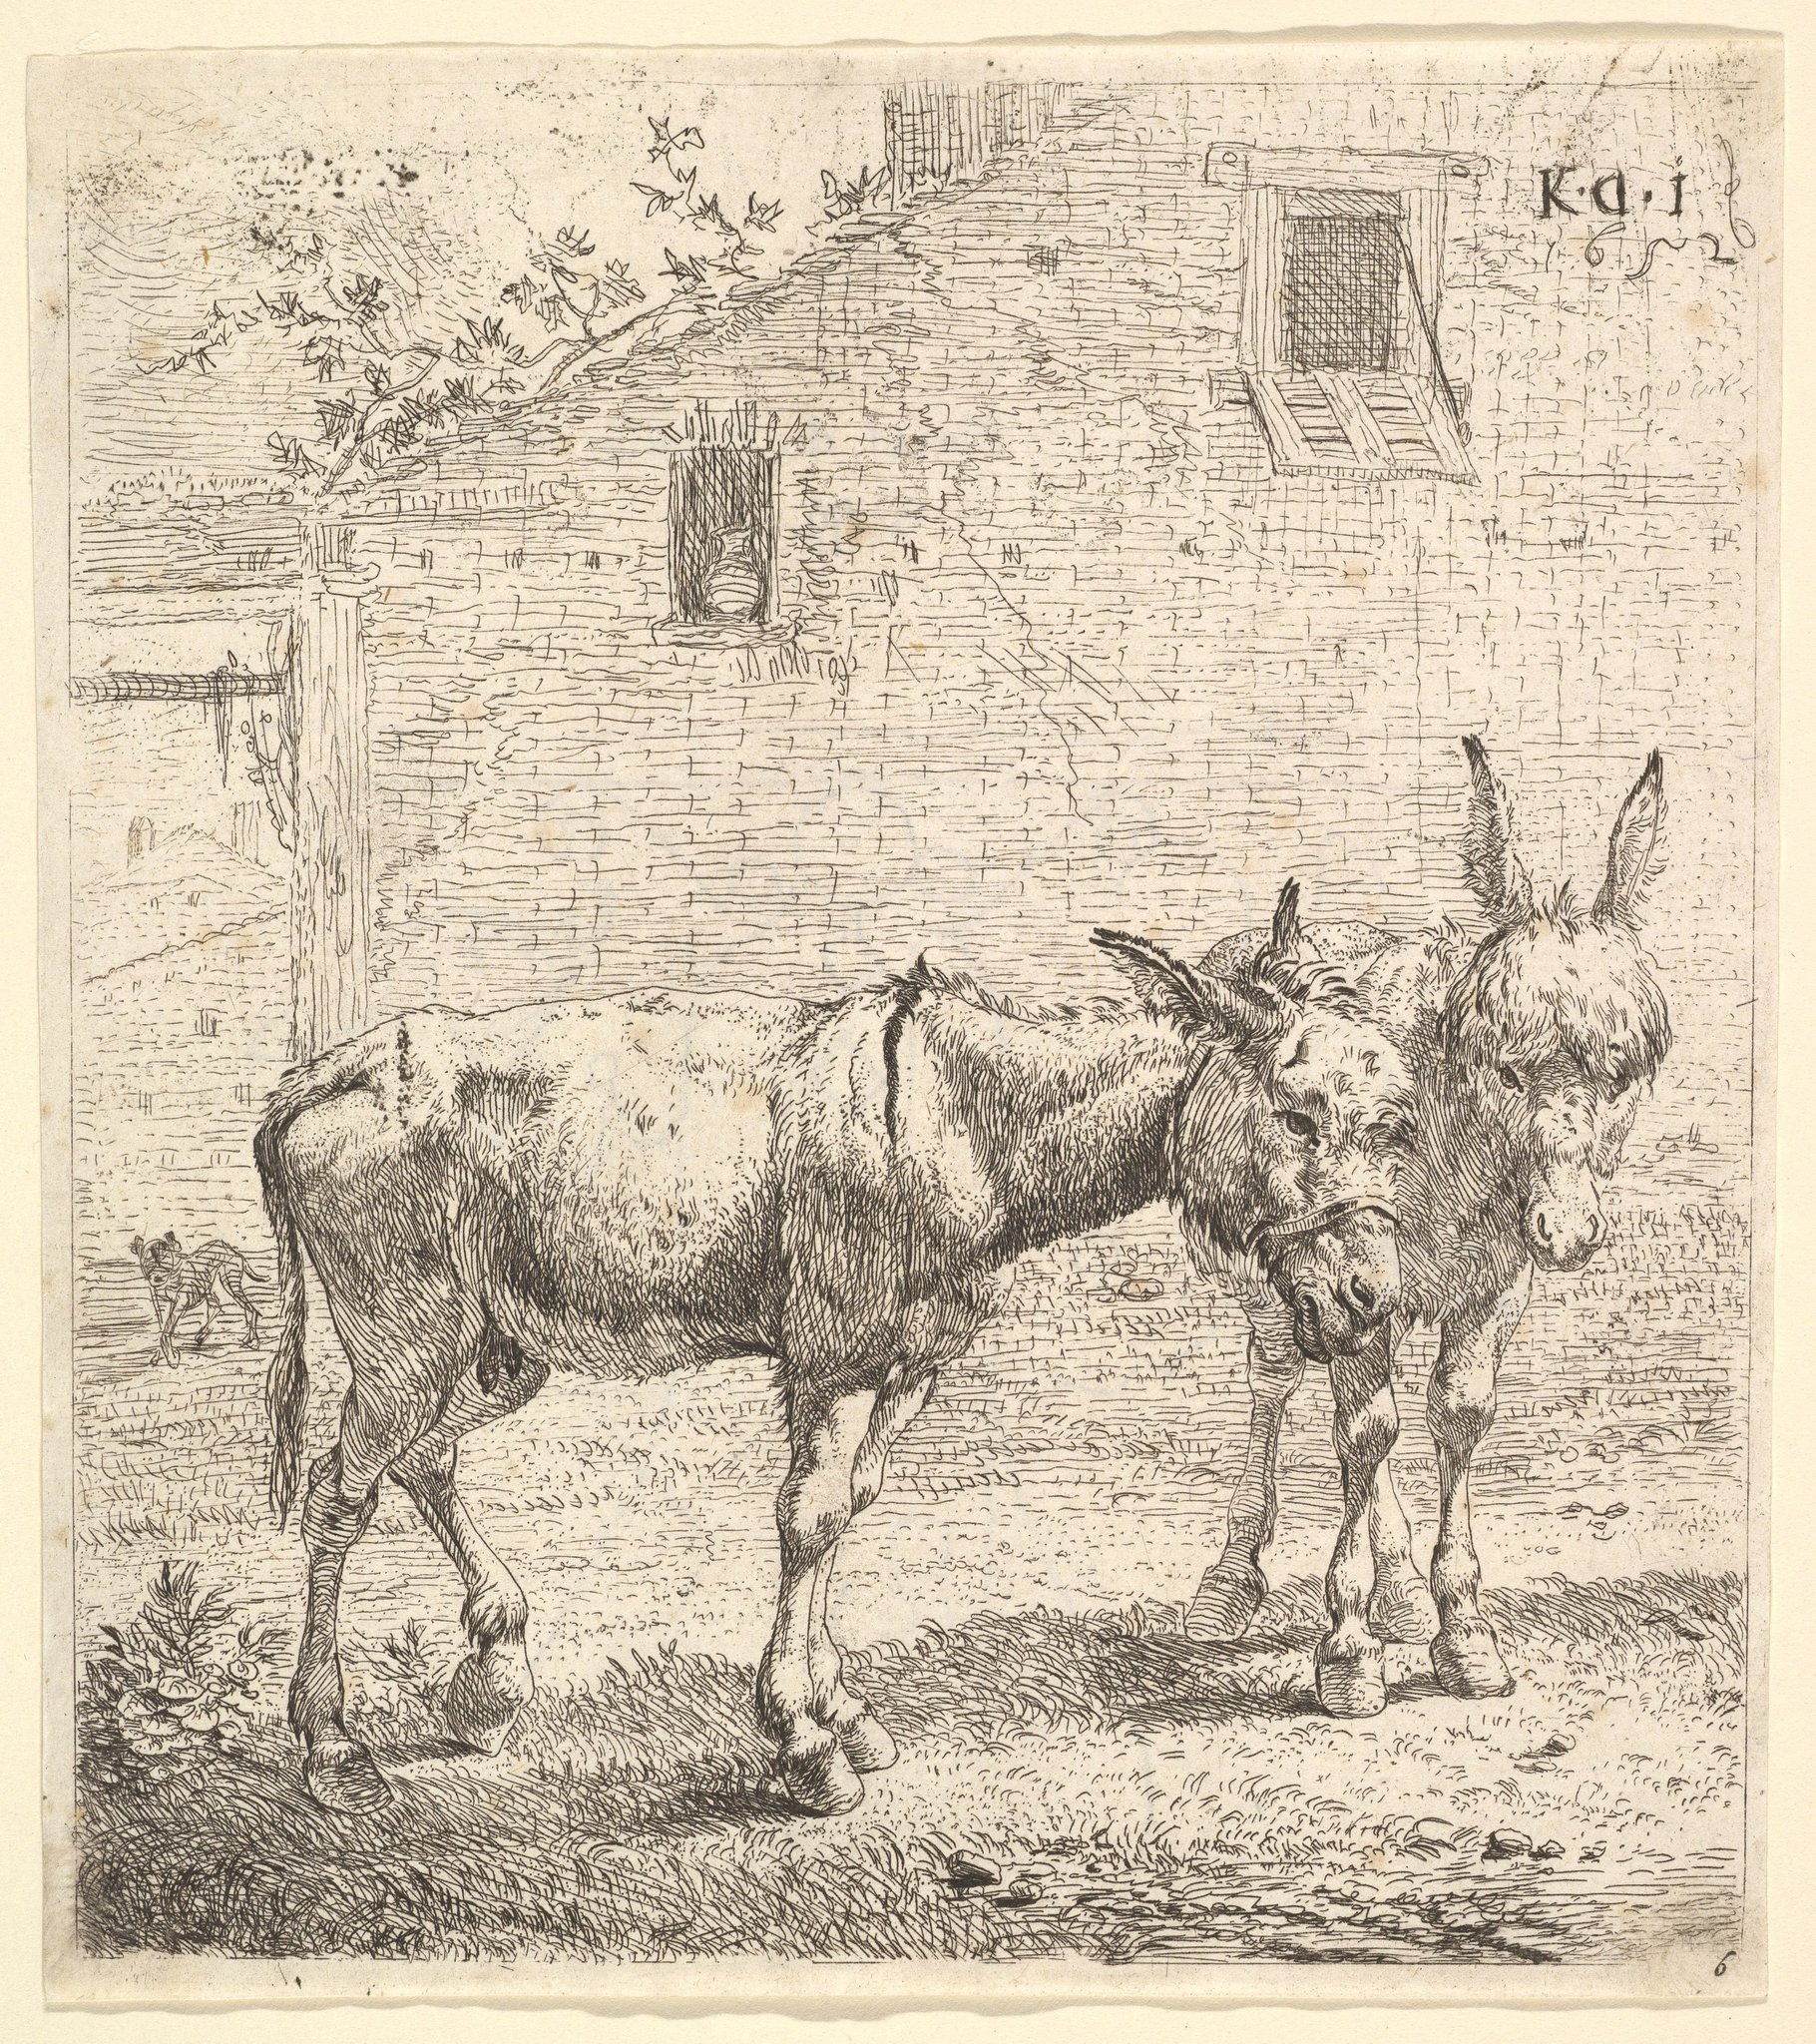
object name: print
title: Two donkeys standing in a grassy yard, one in profile view facing right and another behind in three-quarter view, a dog and a building wall with two windows beyond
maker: karel dujardin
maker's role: artist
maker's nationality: dutch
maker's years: 1622-1678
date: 1652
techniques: etching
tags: buildings,dogs,donkeys